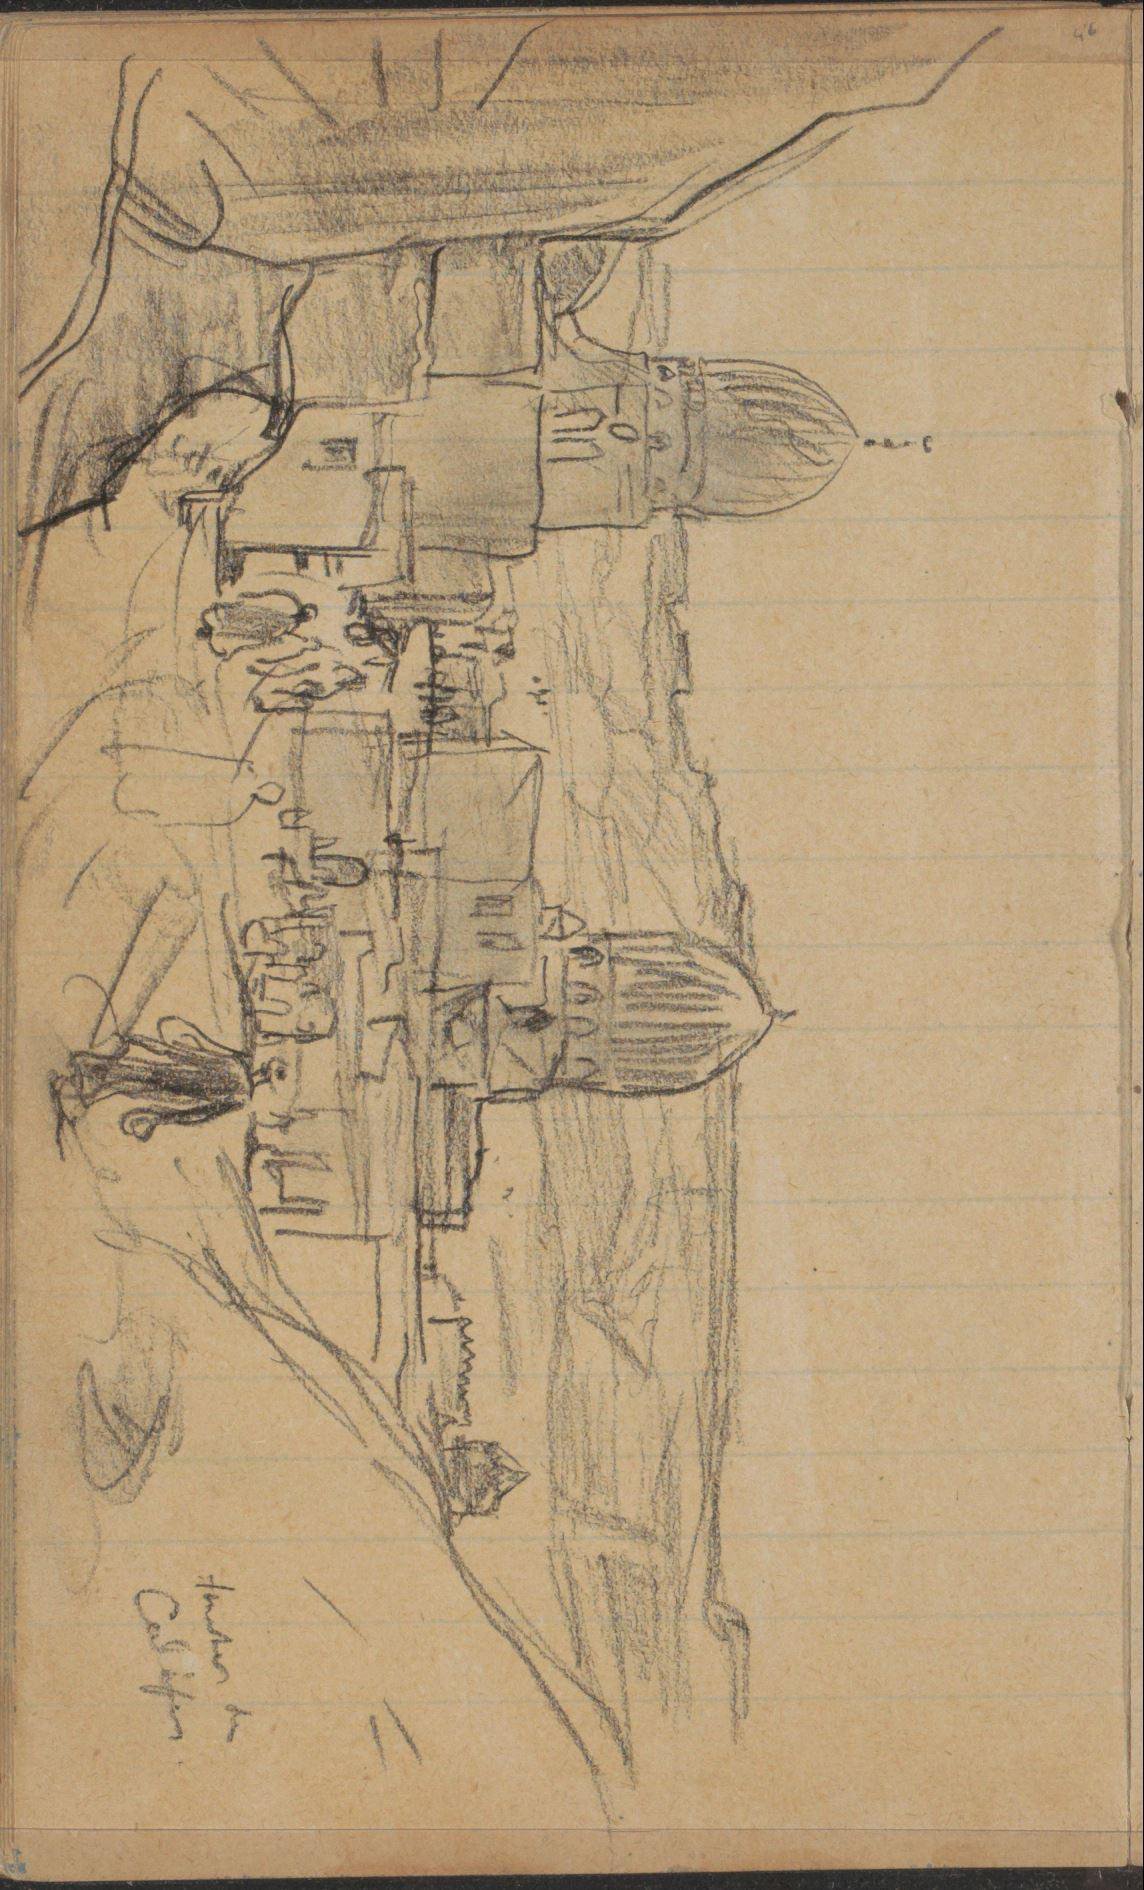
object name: sketchbook leaf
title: Figuren op een weg bij de Graven van de Kaliefen in Caïro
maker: marius bauer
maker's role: draughtsman, print maker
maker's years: 1867-1932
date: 1894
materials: chalk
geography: cairo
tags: city-view, and landscape with man-made constructions, grave-building, monumental tomb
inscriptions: annotation: ‘tombes der/ Califen.’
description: Pagina 46 uit een schetsboek met 48 bladen.